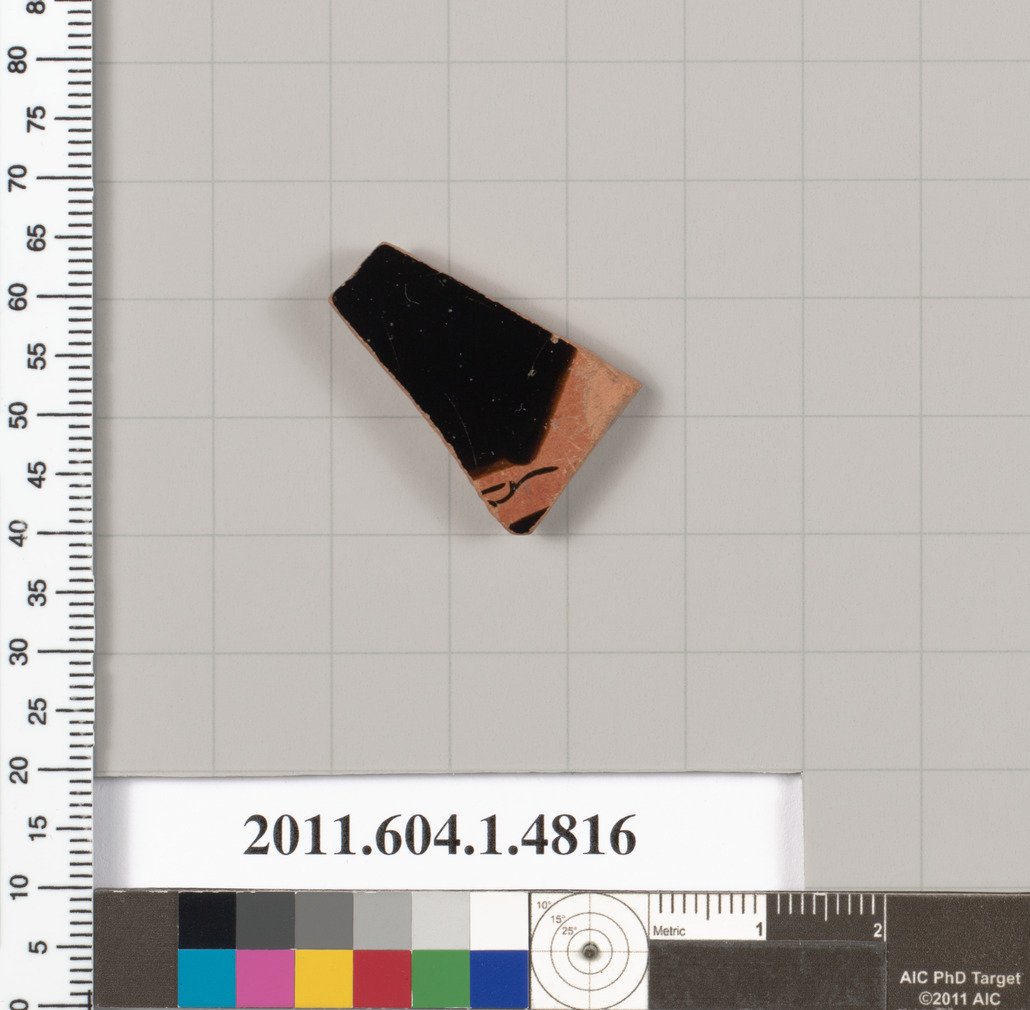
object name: kylix fragment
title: Terracotta fragment of a kylix (drinking cup)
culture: greek, attic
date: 490-480 BCE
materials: terracotta